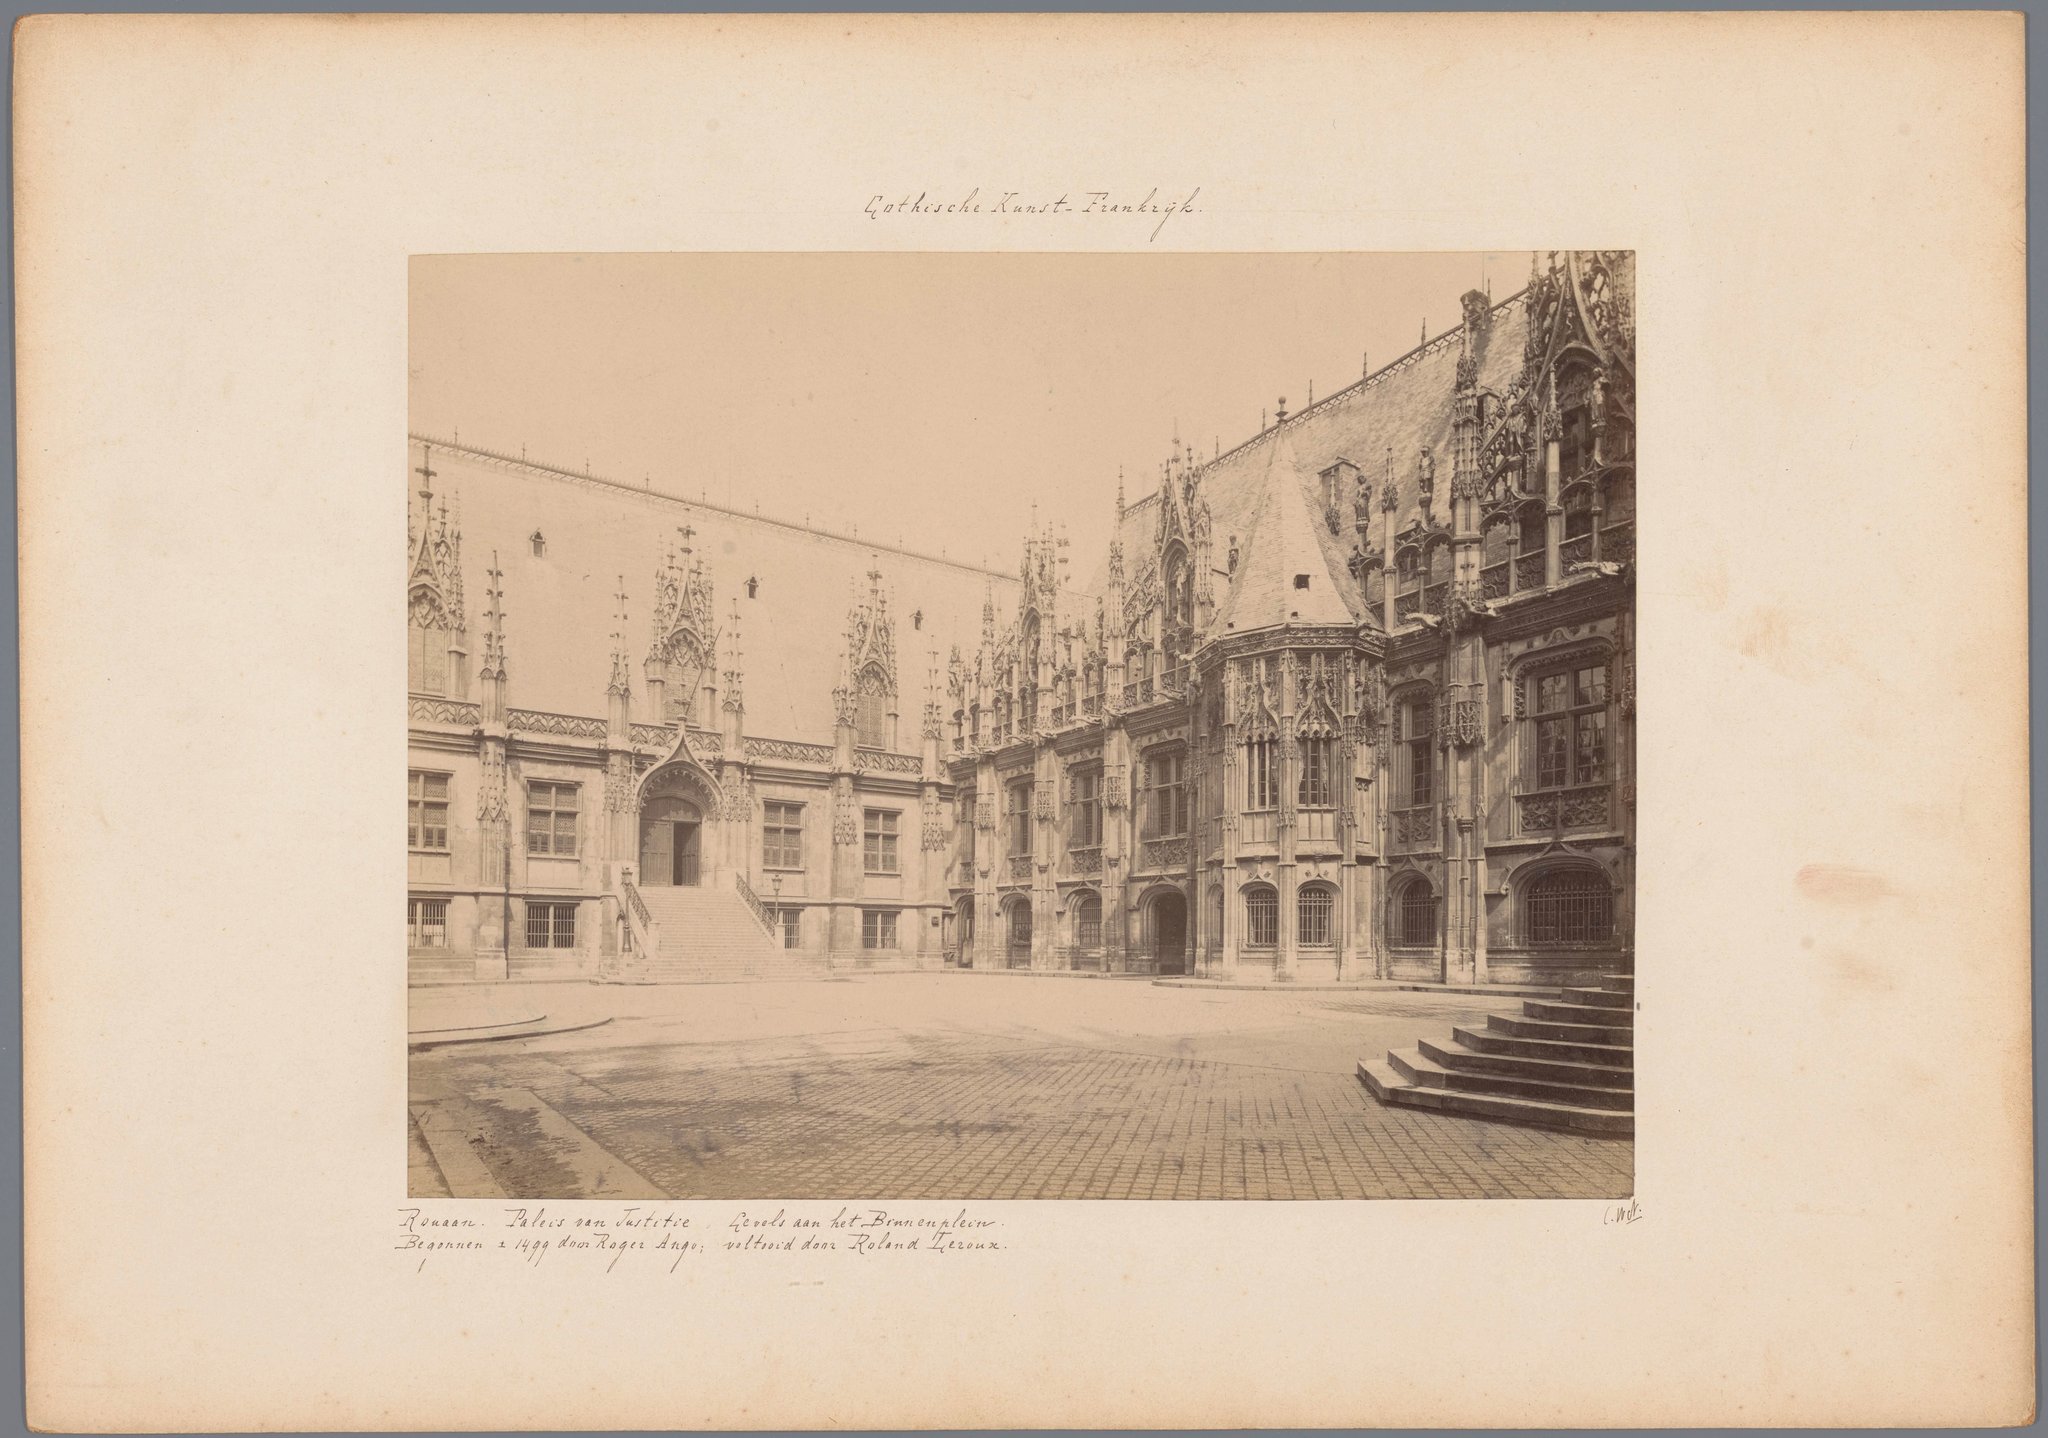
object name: photograph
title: Rouaan. Paleis van Justitie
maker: Anonymous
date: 1875-1900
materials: cardboard, photographic support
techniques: albumen print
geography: rouen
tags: court building, courtyard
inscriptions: inscription: ‘CWN.’, inscription: ‘Gothische Kunst - Frankrijk.’, collector's mark: ‘KUNSTNIJVERHEIDSCHOOL QUELLINUS AMSTERDAM FRANS HALSSTRAAT 14.’, collector's mark: ‘INSTITUUT VOOR KUNST-NIJVERHEIDSONDERWIJS GABRIËL METSUSTRAAT No. 16 AMSTERDAM’